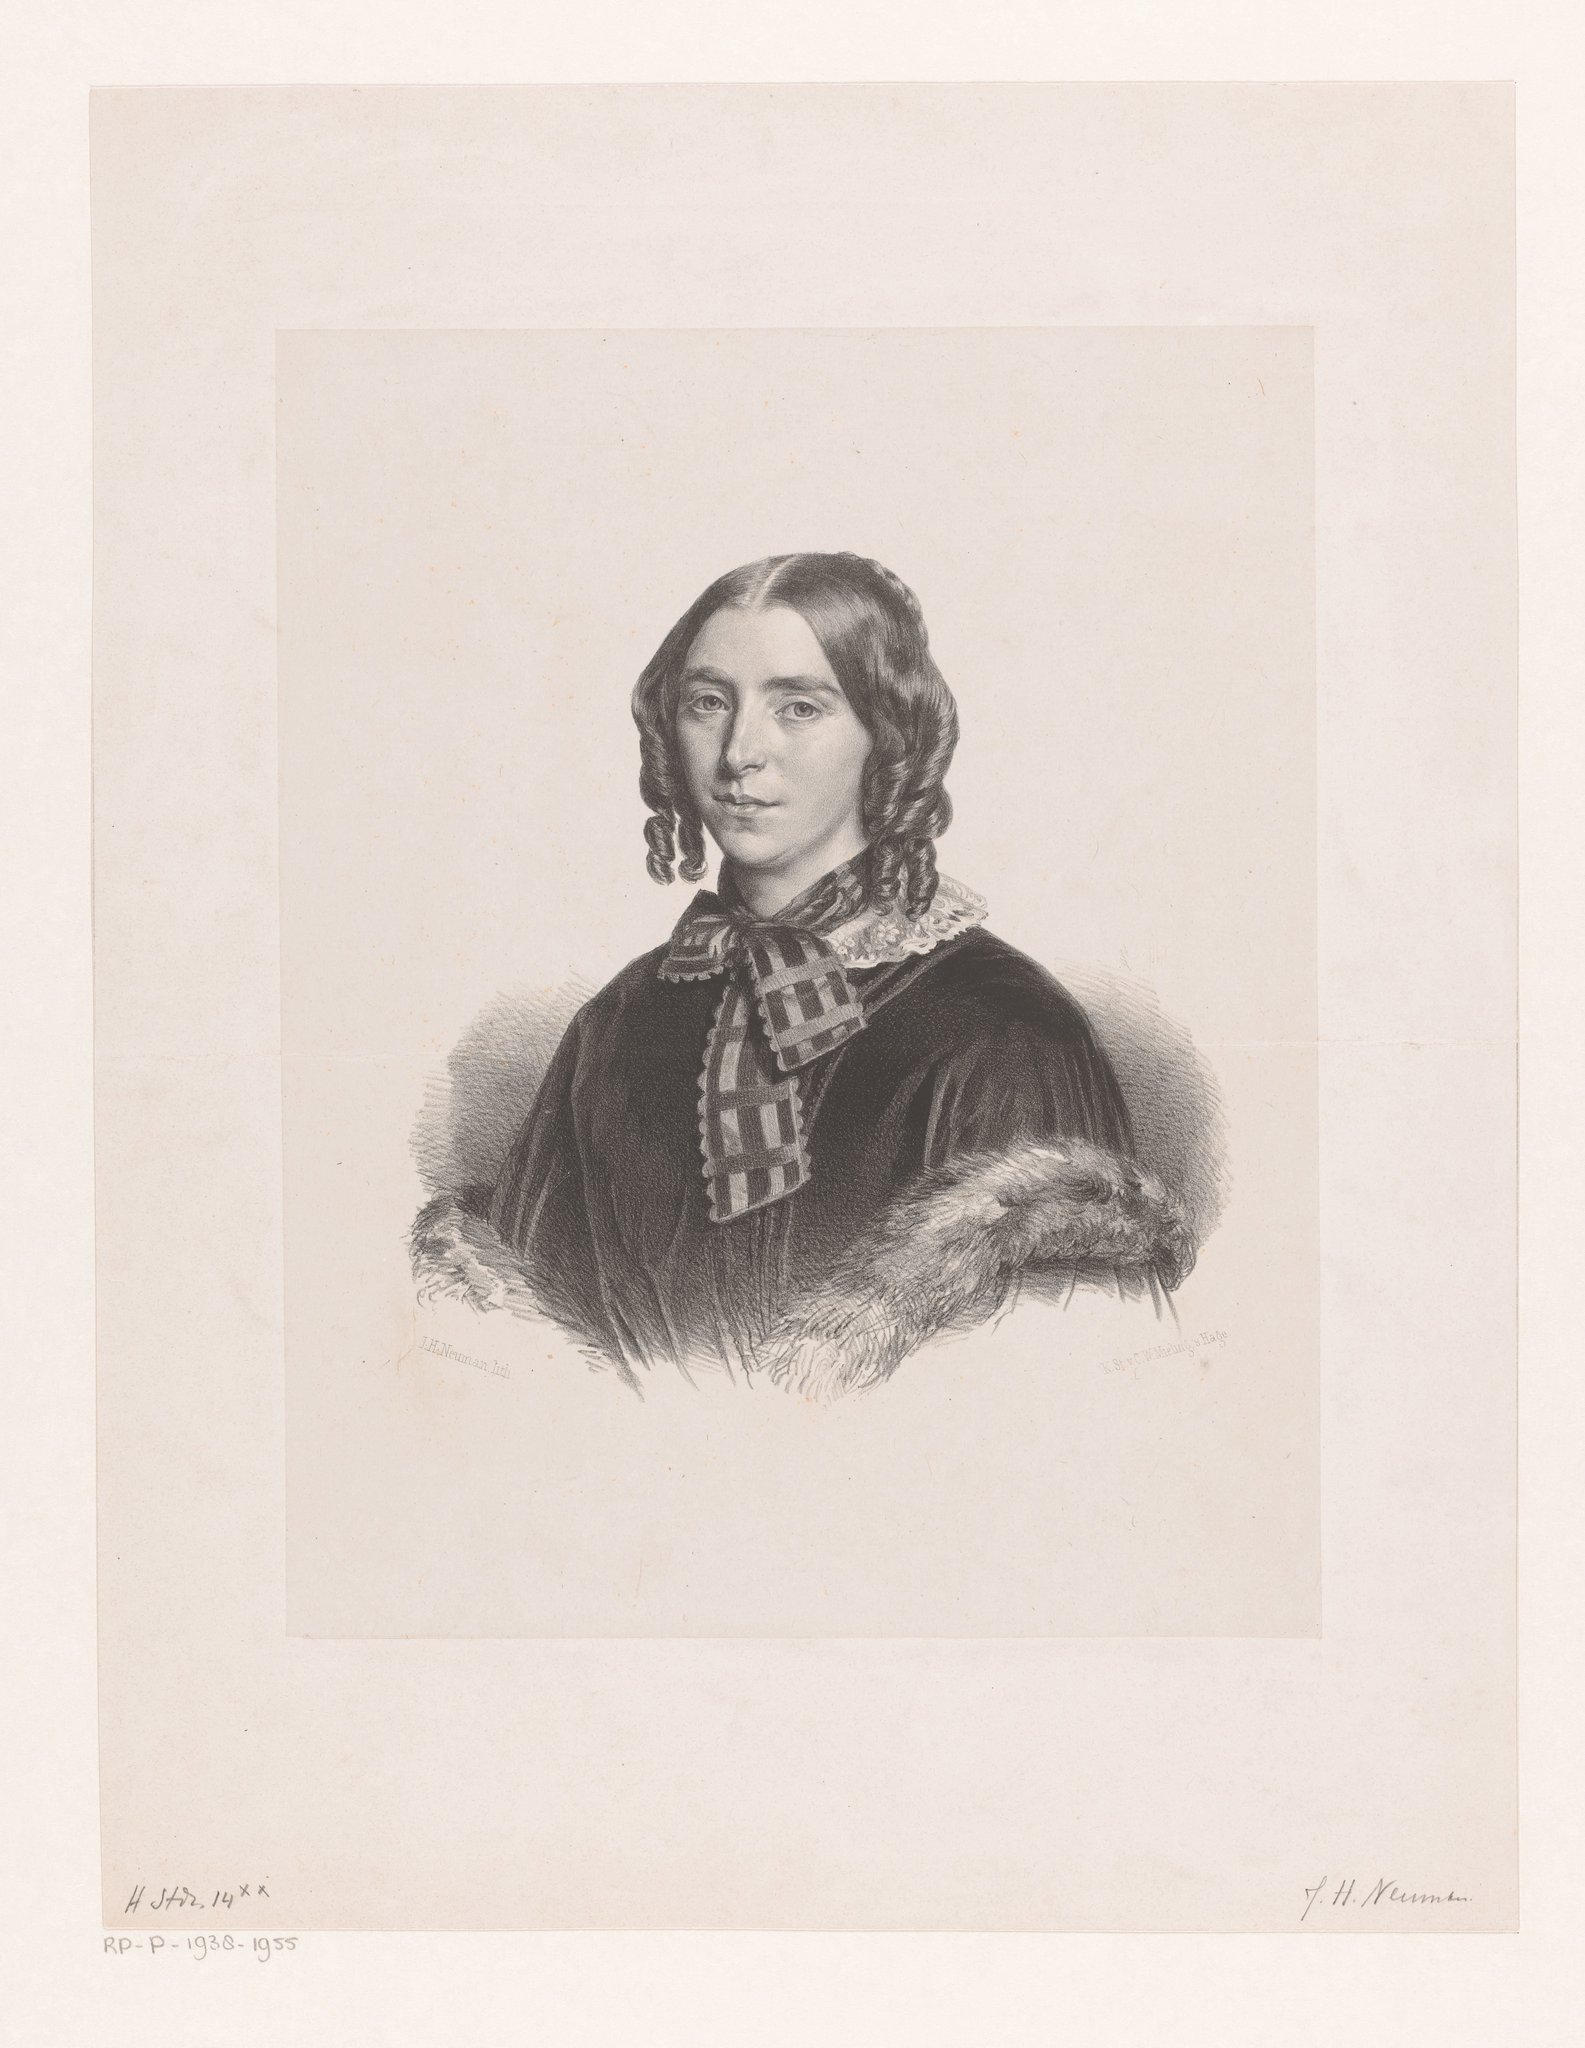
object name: print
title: Portret van een onbekende vrouw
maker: johan heinrich neuman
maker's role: draughtsman, painter, print maker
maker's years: 1819-1898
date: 1847-1865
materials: paper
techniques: lithograph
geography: the hague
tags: anonymous historical person portrayed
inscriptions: collector's mark: Lugt 2760